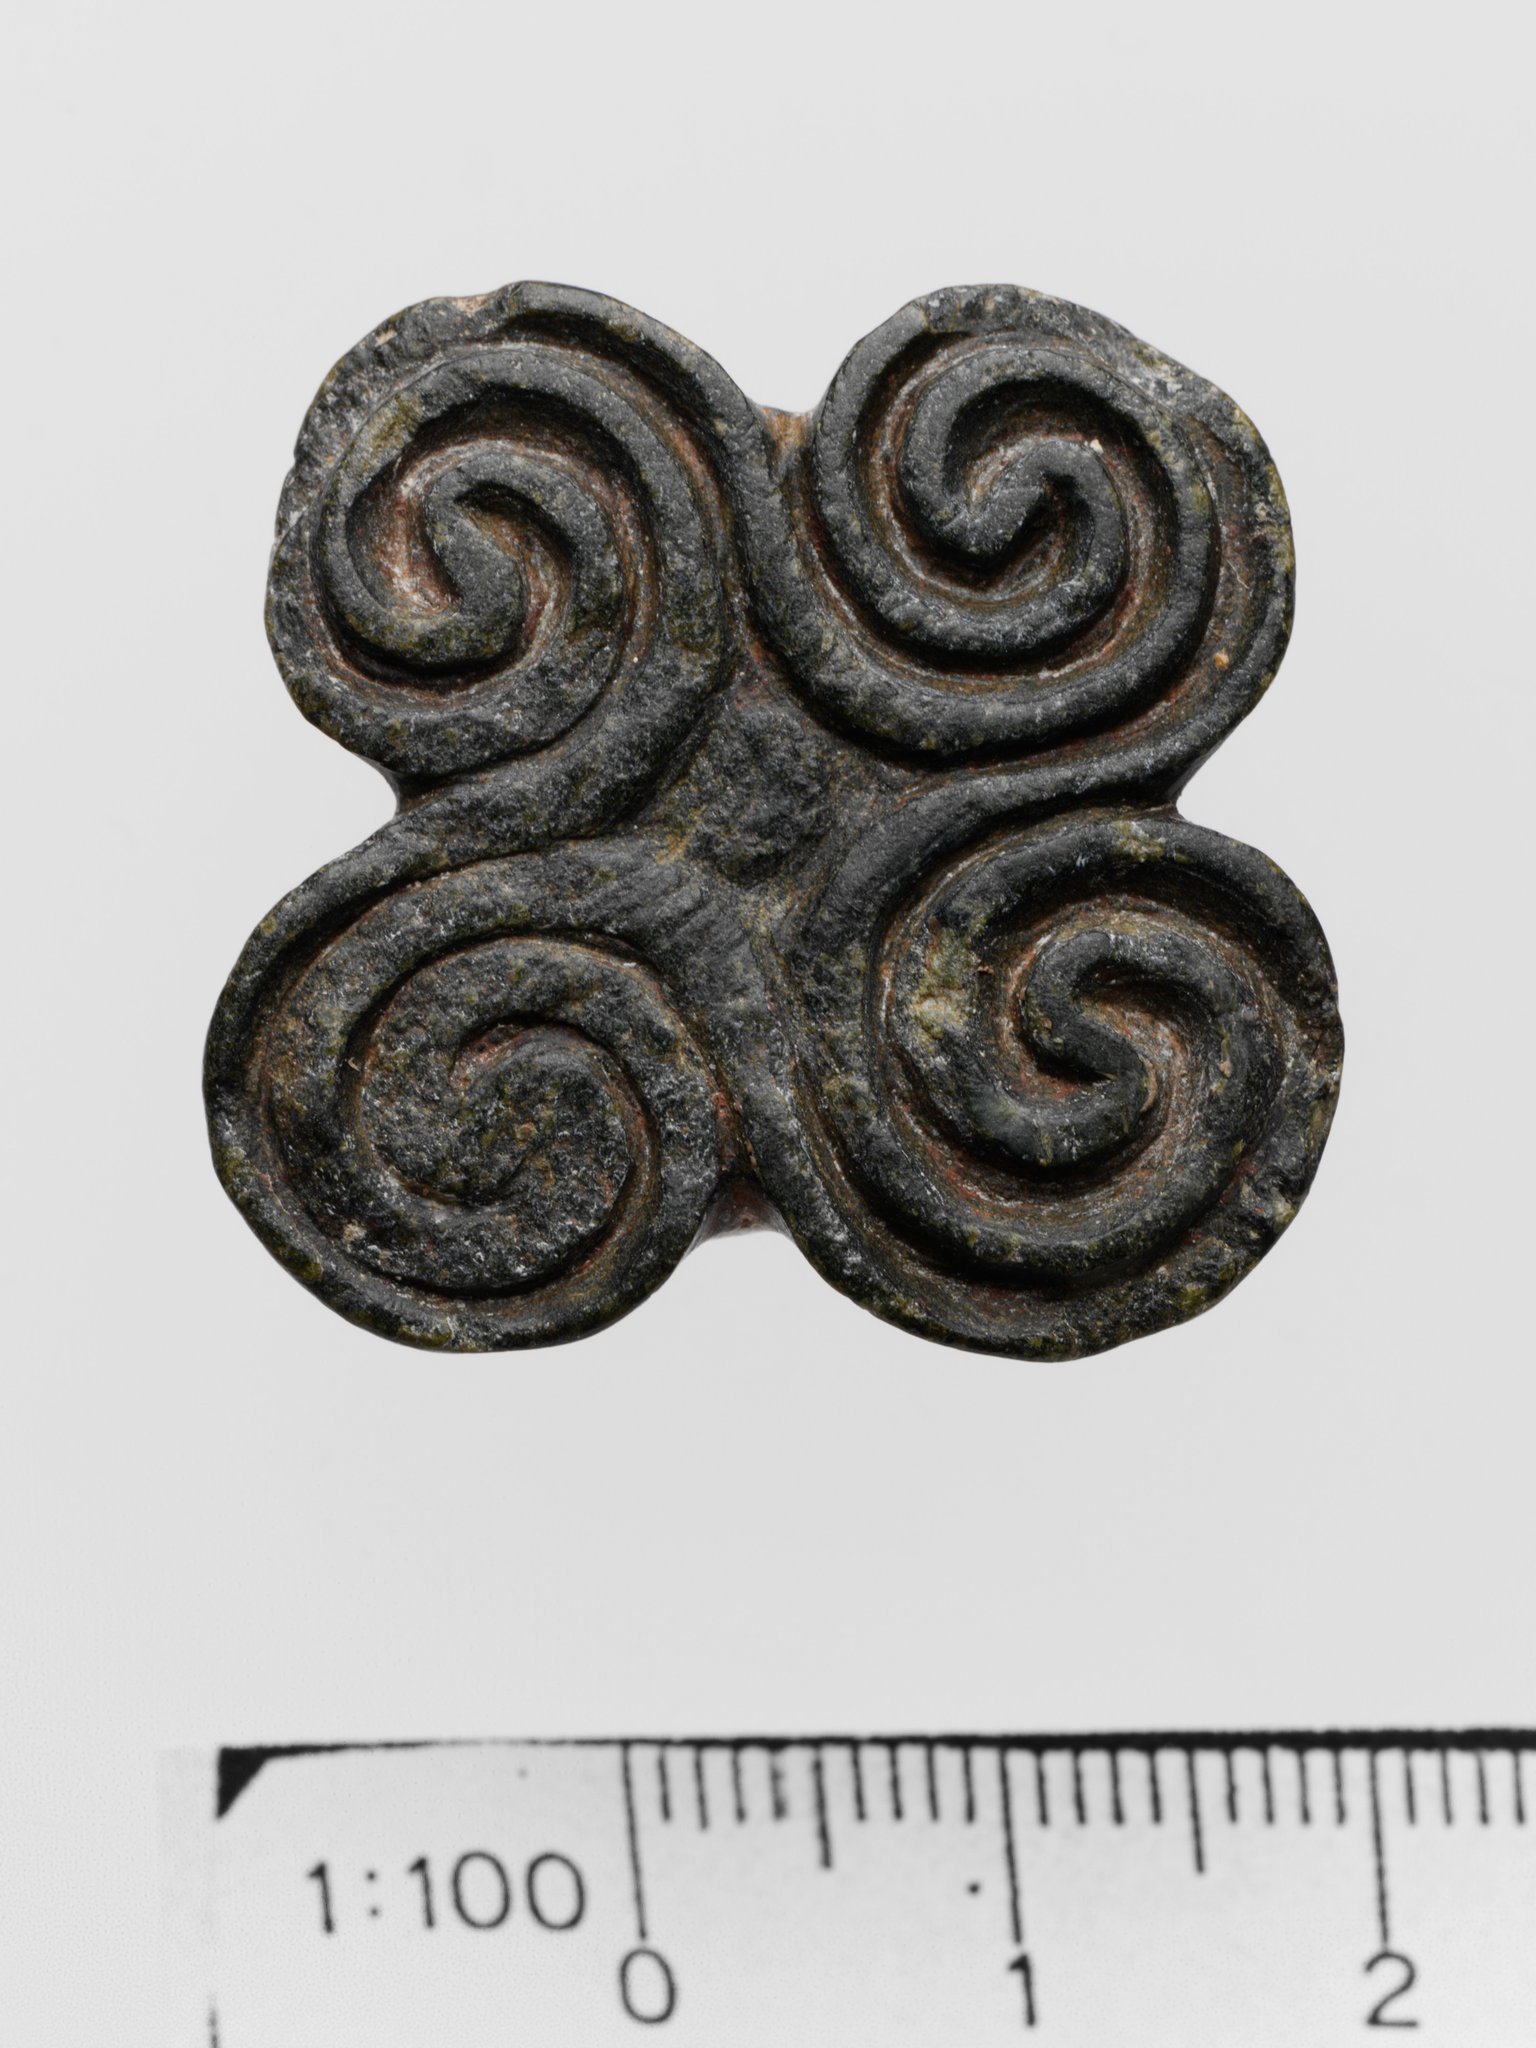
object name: stamp seal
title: Steatite seal with bridge handle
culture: minoan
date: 2900-2200 BCE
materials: stone